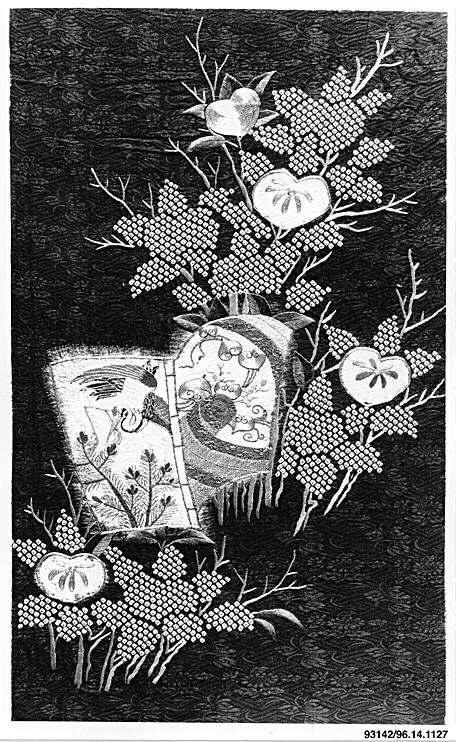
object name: panel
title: Panel with Design of Mandarin Oranges and Booklet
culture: japanese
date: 1701-1800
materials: metal thread, textile, silk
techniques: damask, dyeing, embroidery, resist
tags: books,fruit